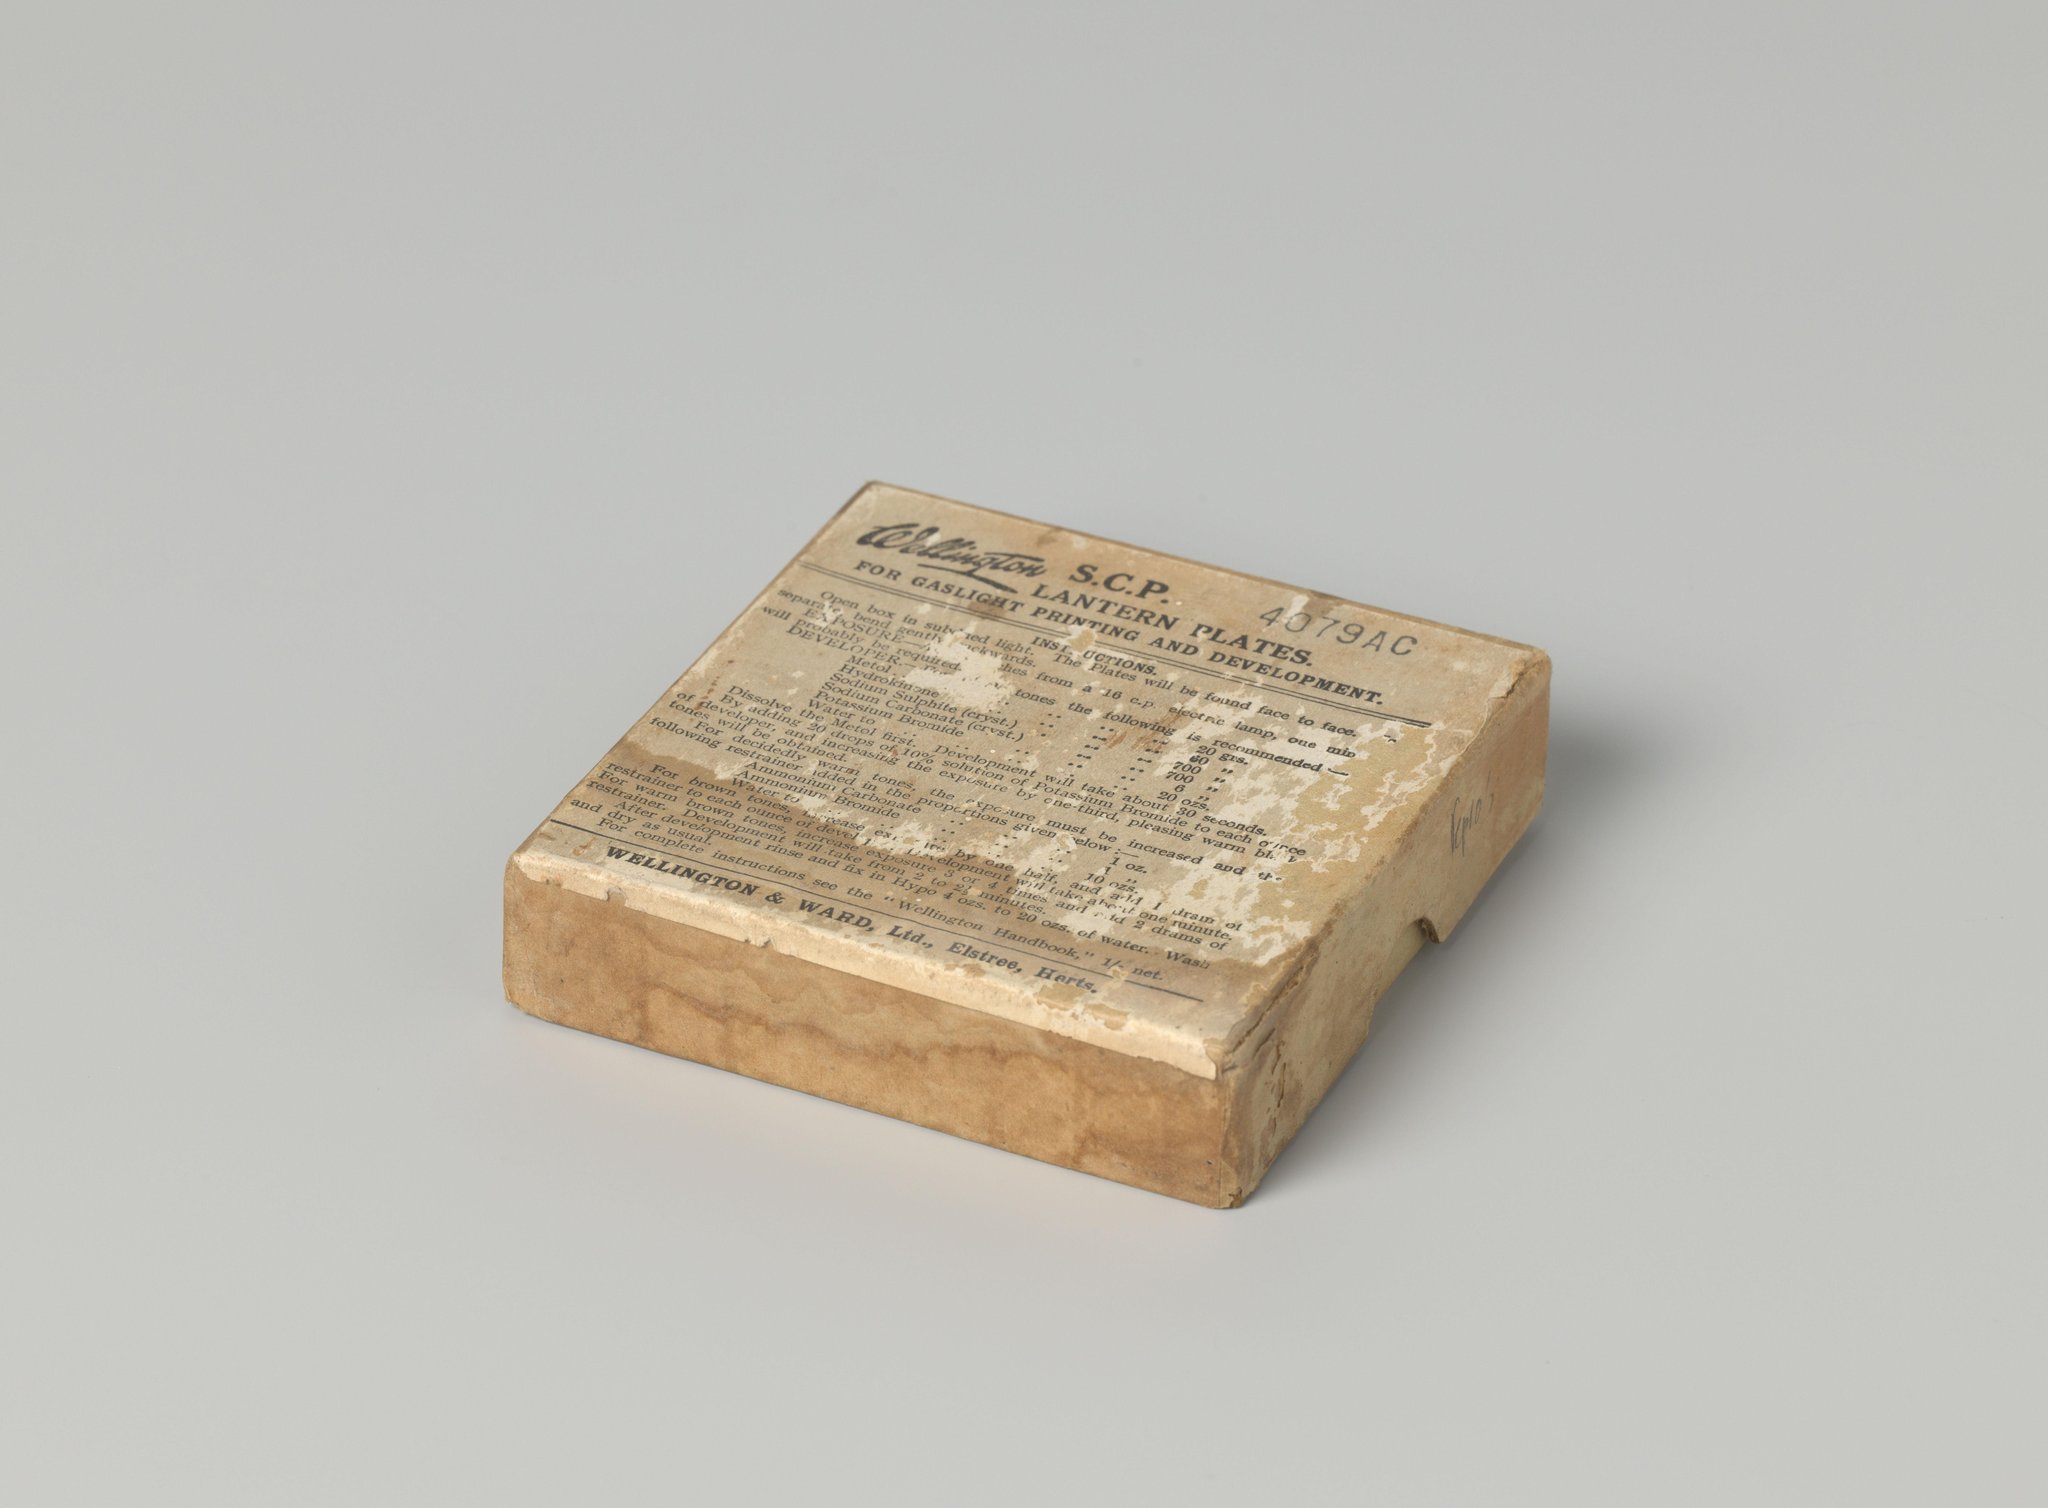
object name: box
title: Doos voor glasplaten van Wellington & Ward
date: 1890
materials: cardboard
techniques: printing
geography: elstree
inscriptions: number: ‘4079AC’, inscription: ‘repro's’